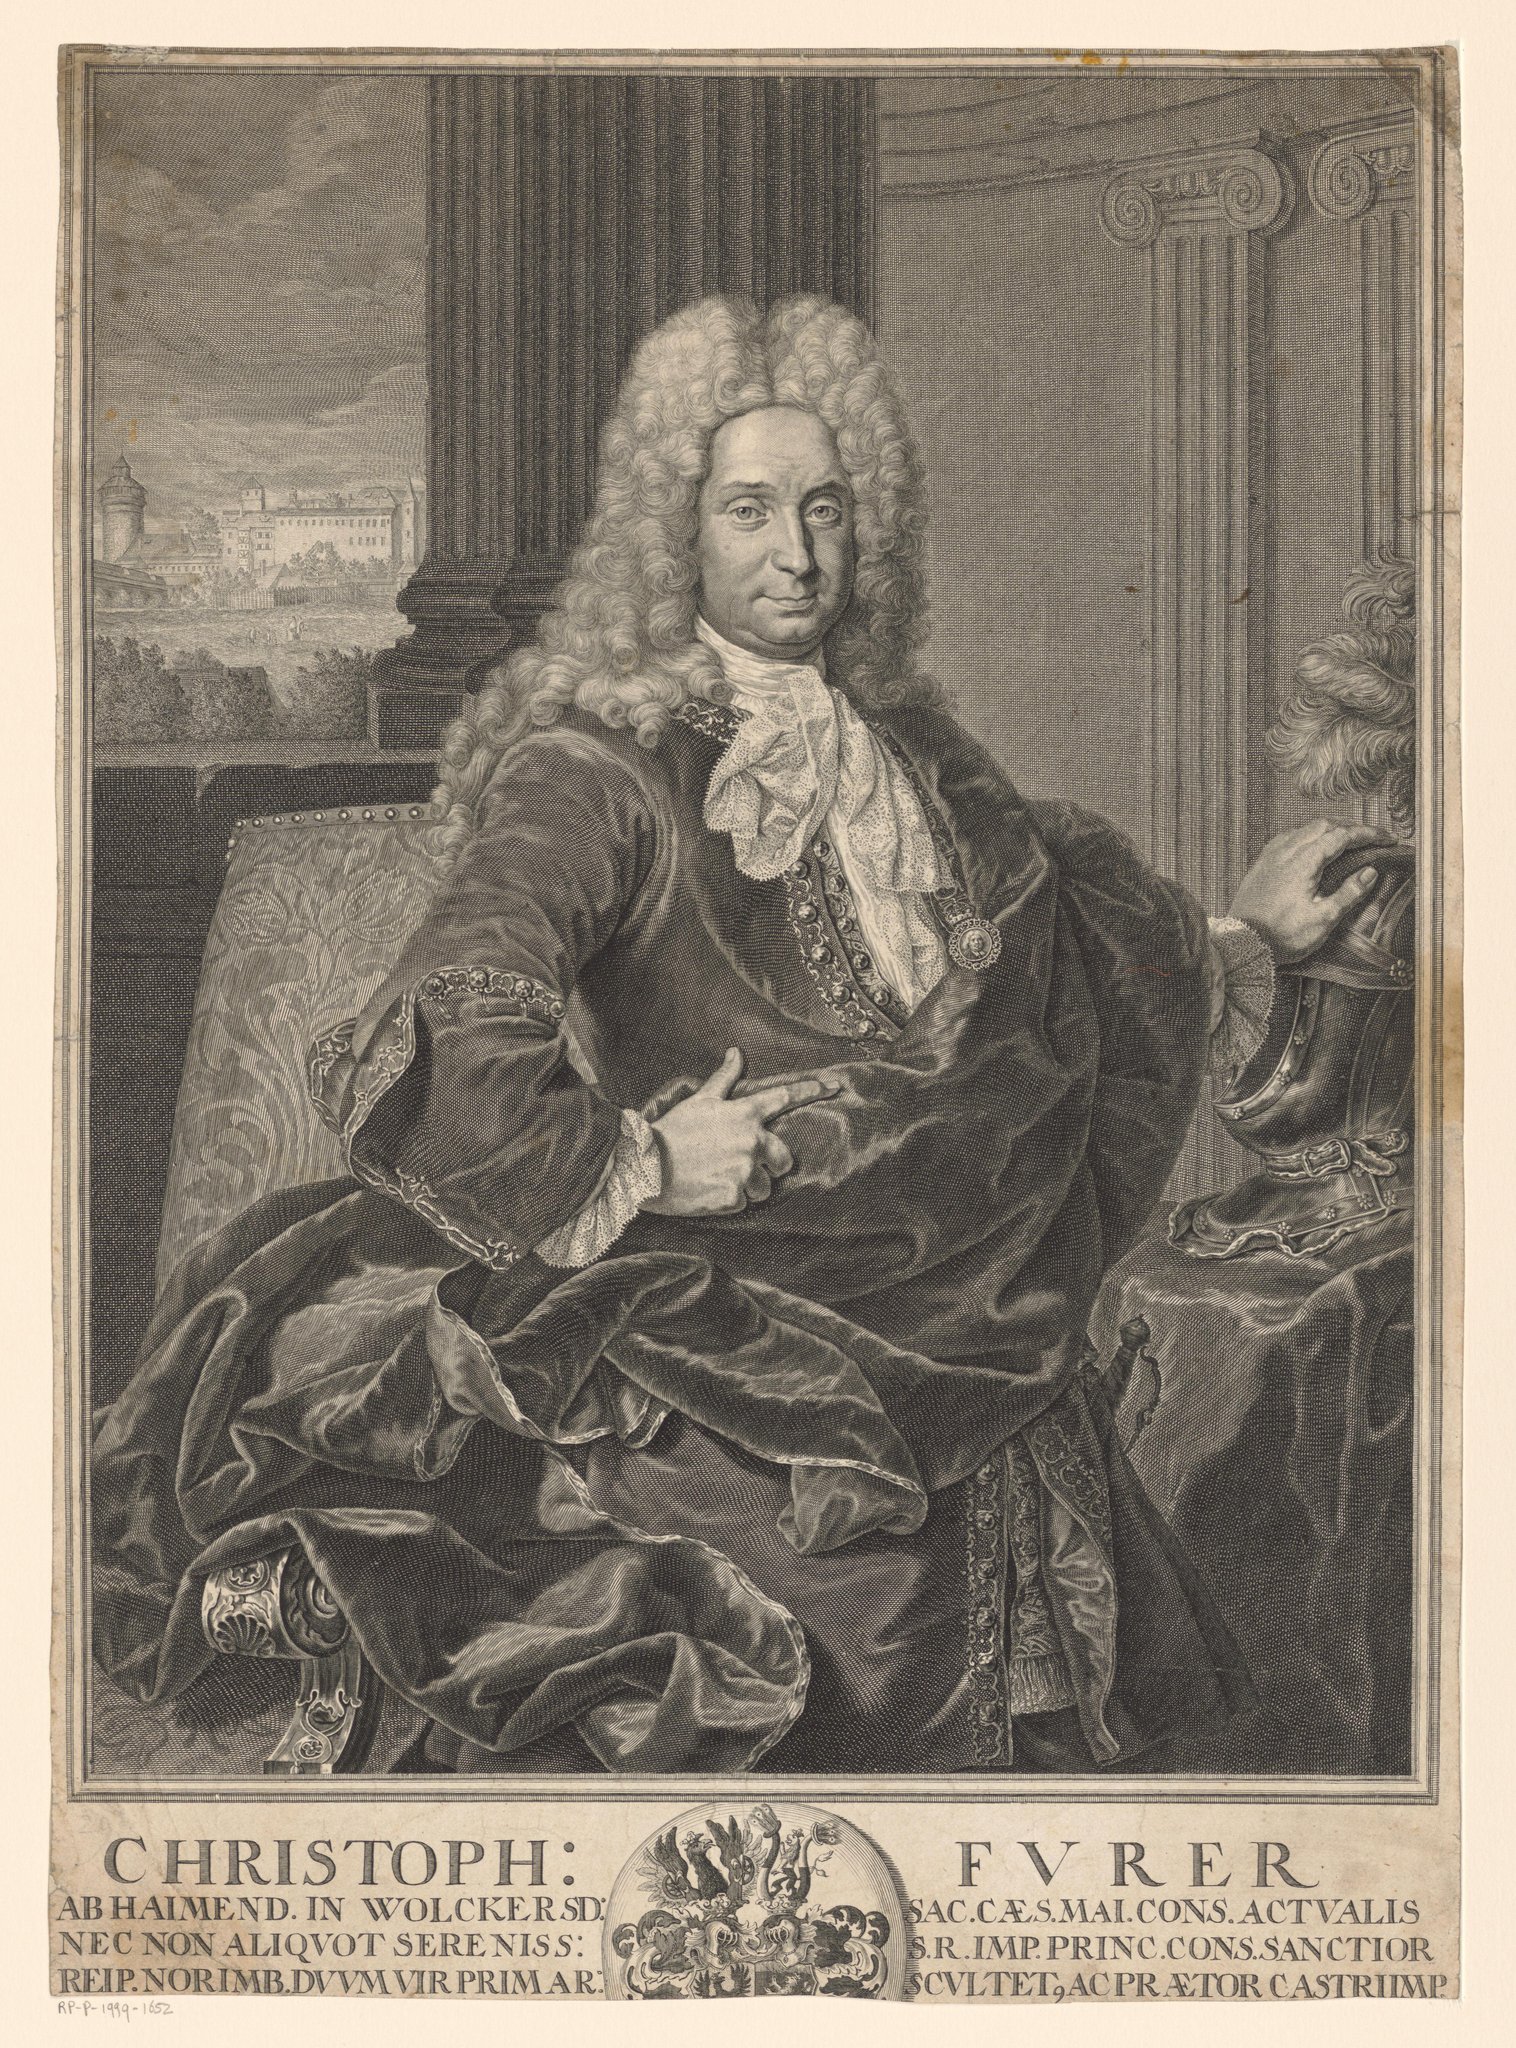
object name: print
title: Portret van Christoph Fürer von Haimendorf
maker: johann wilhelm windter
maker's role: draughtsman, print maker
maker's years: 1696-1765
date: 1733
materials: paper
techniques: engraving, etching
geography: nuremberg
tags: mayor, helmet, castle, historical persons, armorial bearing, heraldry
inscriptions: inscription: ‘JW Windter sc’, collector's mark: Lugt 2228, collector's mark: Lugt 2760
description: Links een gezicht op het kasteel van Neurenberg. Met onderschrift in het Latijn.